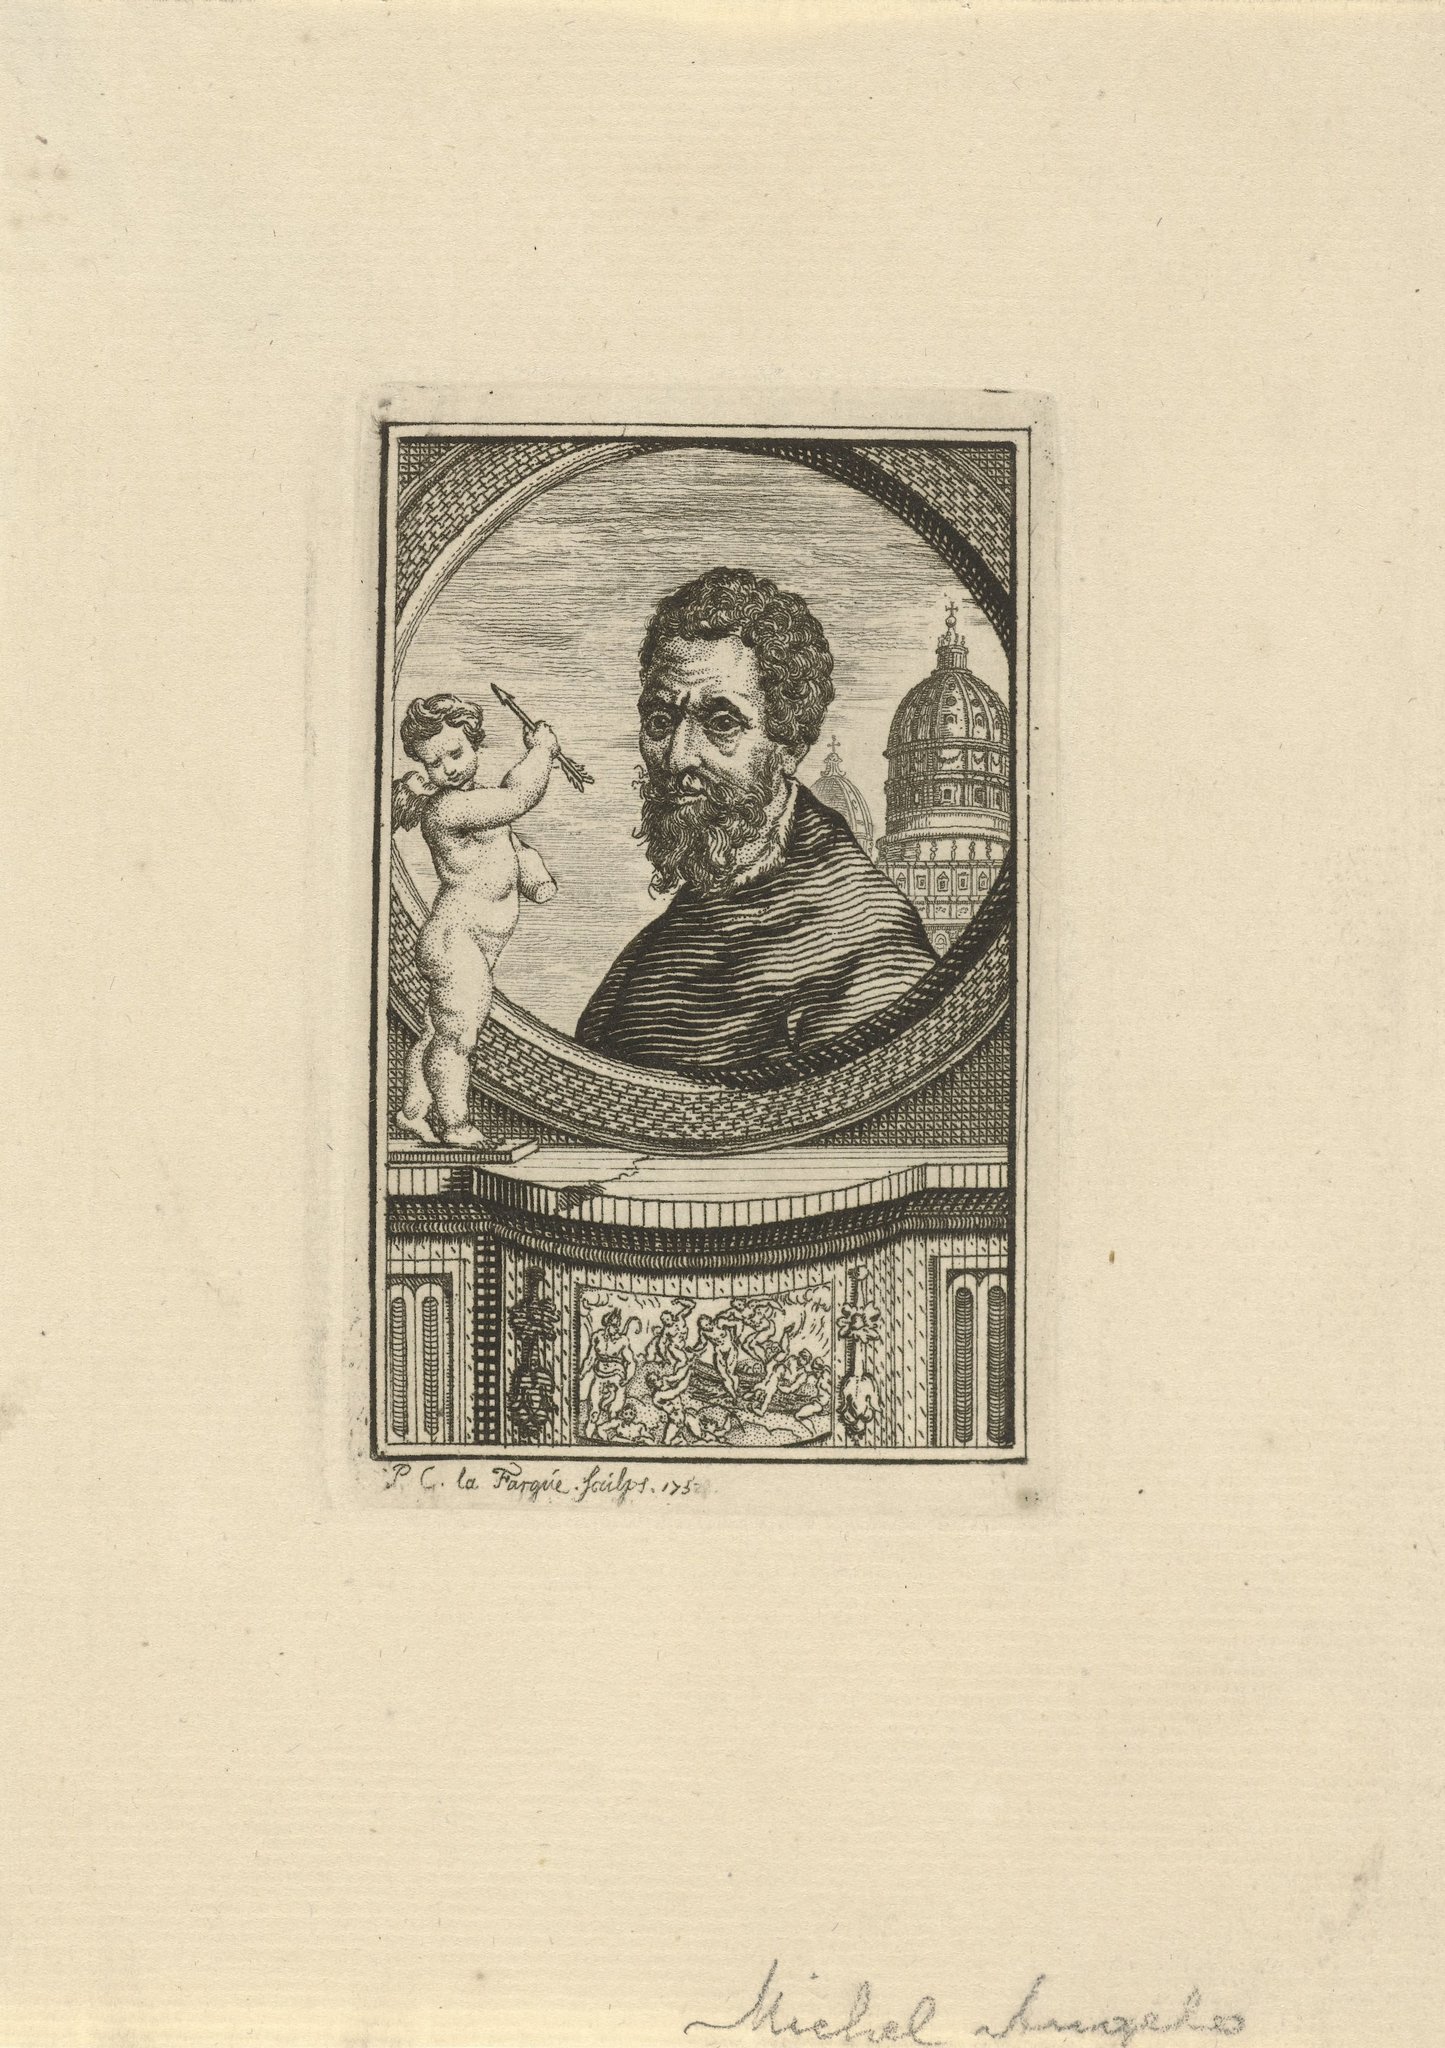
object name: print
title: Portret van Michelangelo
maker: isaac lodewijk la fargue van nieuwland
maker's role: draughtsman, painter, print maker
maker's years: 1726-1805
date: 1752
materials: paper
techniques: etching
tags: painter, draughtsman, sculptor, michelangelo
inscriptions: collector's mark: Lugt 2228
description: Prent opgenomen in: Dézallier d'Argenville, Antoine Joseph. Tooneel der uitmuntende schilders van Europa, en byzonderlyk van Nederland. Den Haag: Mattheus Gaillard, 1752.